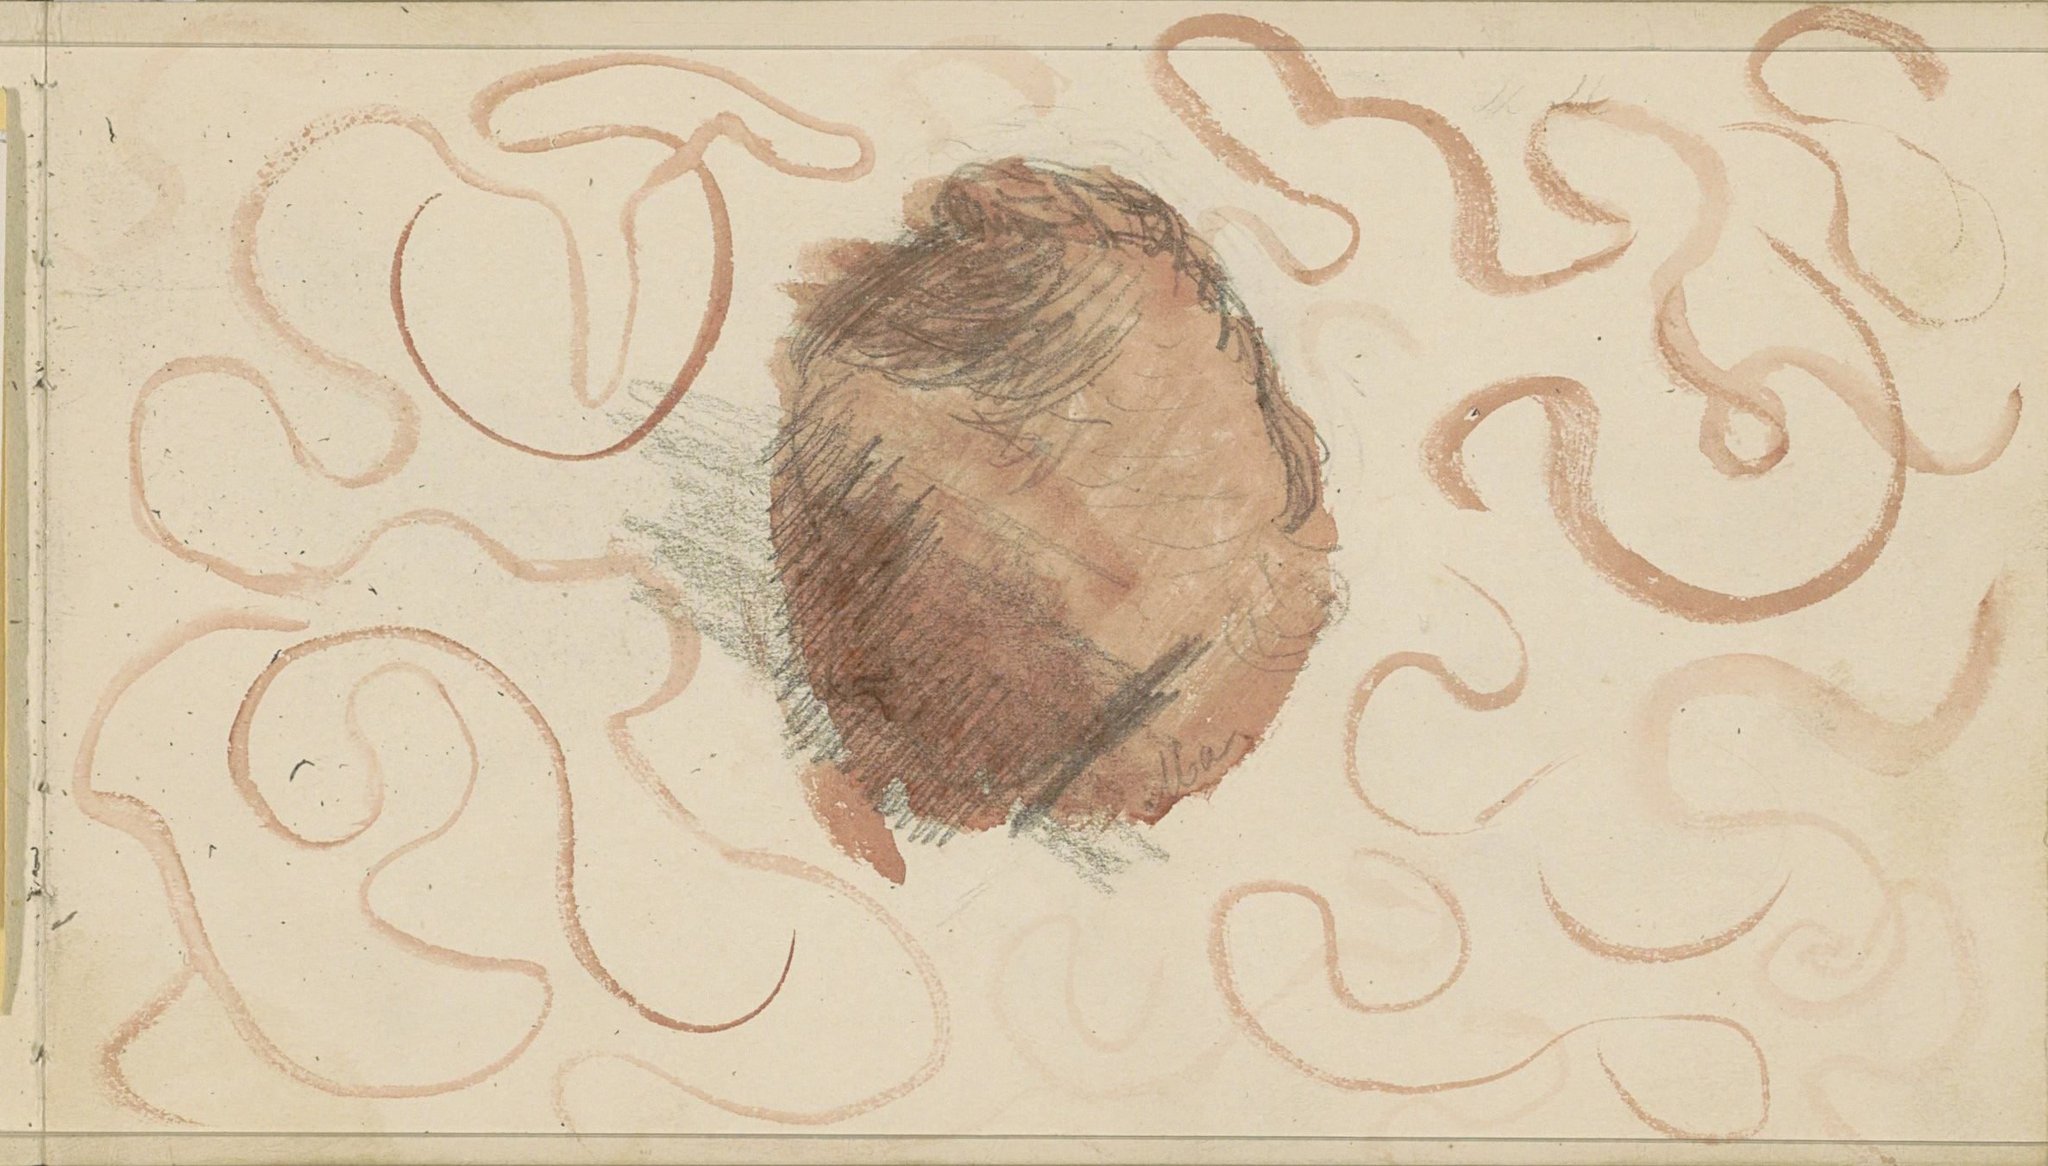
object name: sketchbook leaf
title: Bol omgeven door krullende lijnen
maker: julie de graag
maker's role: draughtsman, print maker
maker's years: 1877-1924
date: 1892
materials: paper, pencil, watercolor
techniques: brush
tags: irregularly curved line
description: Blad 2 recto uit een schetsboek met 22 bladen.